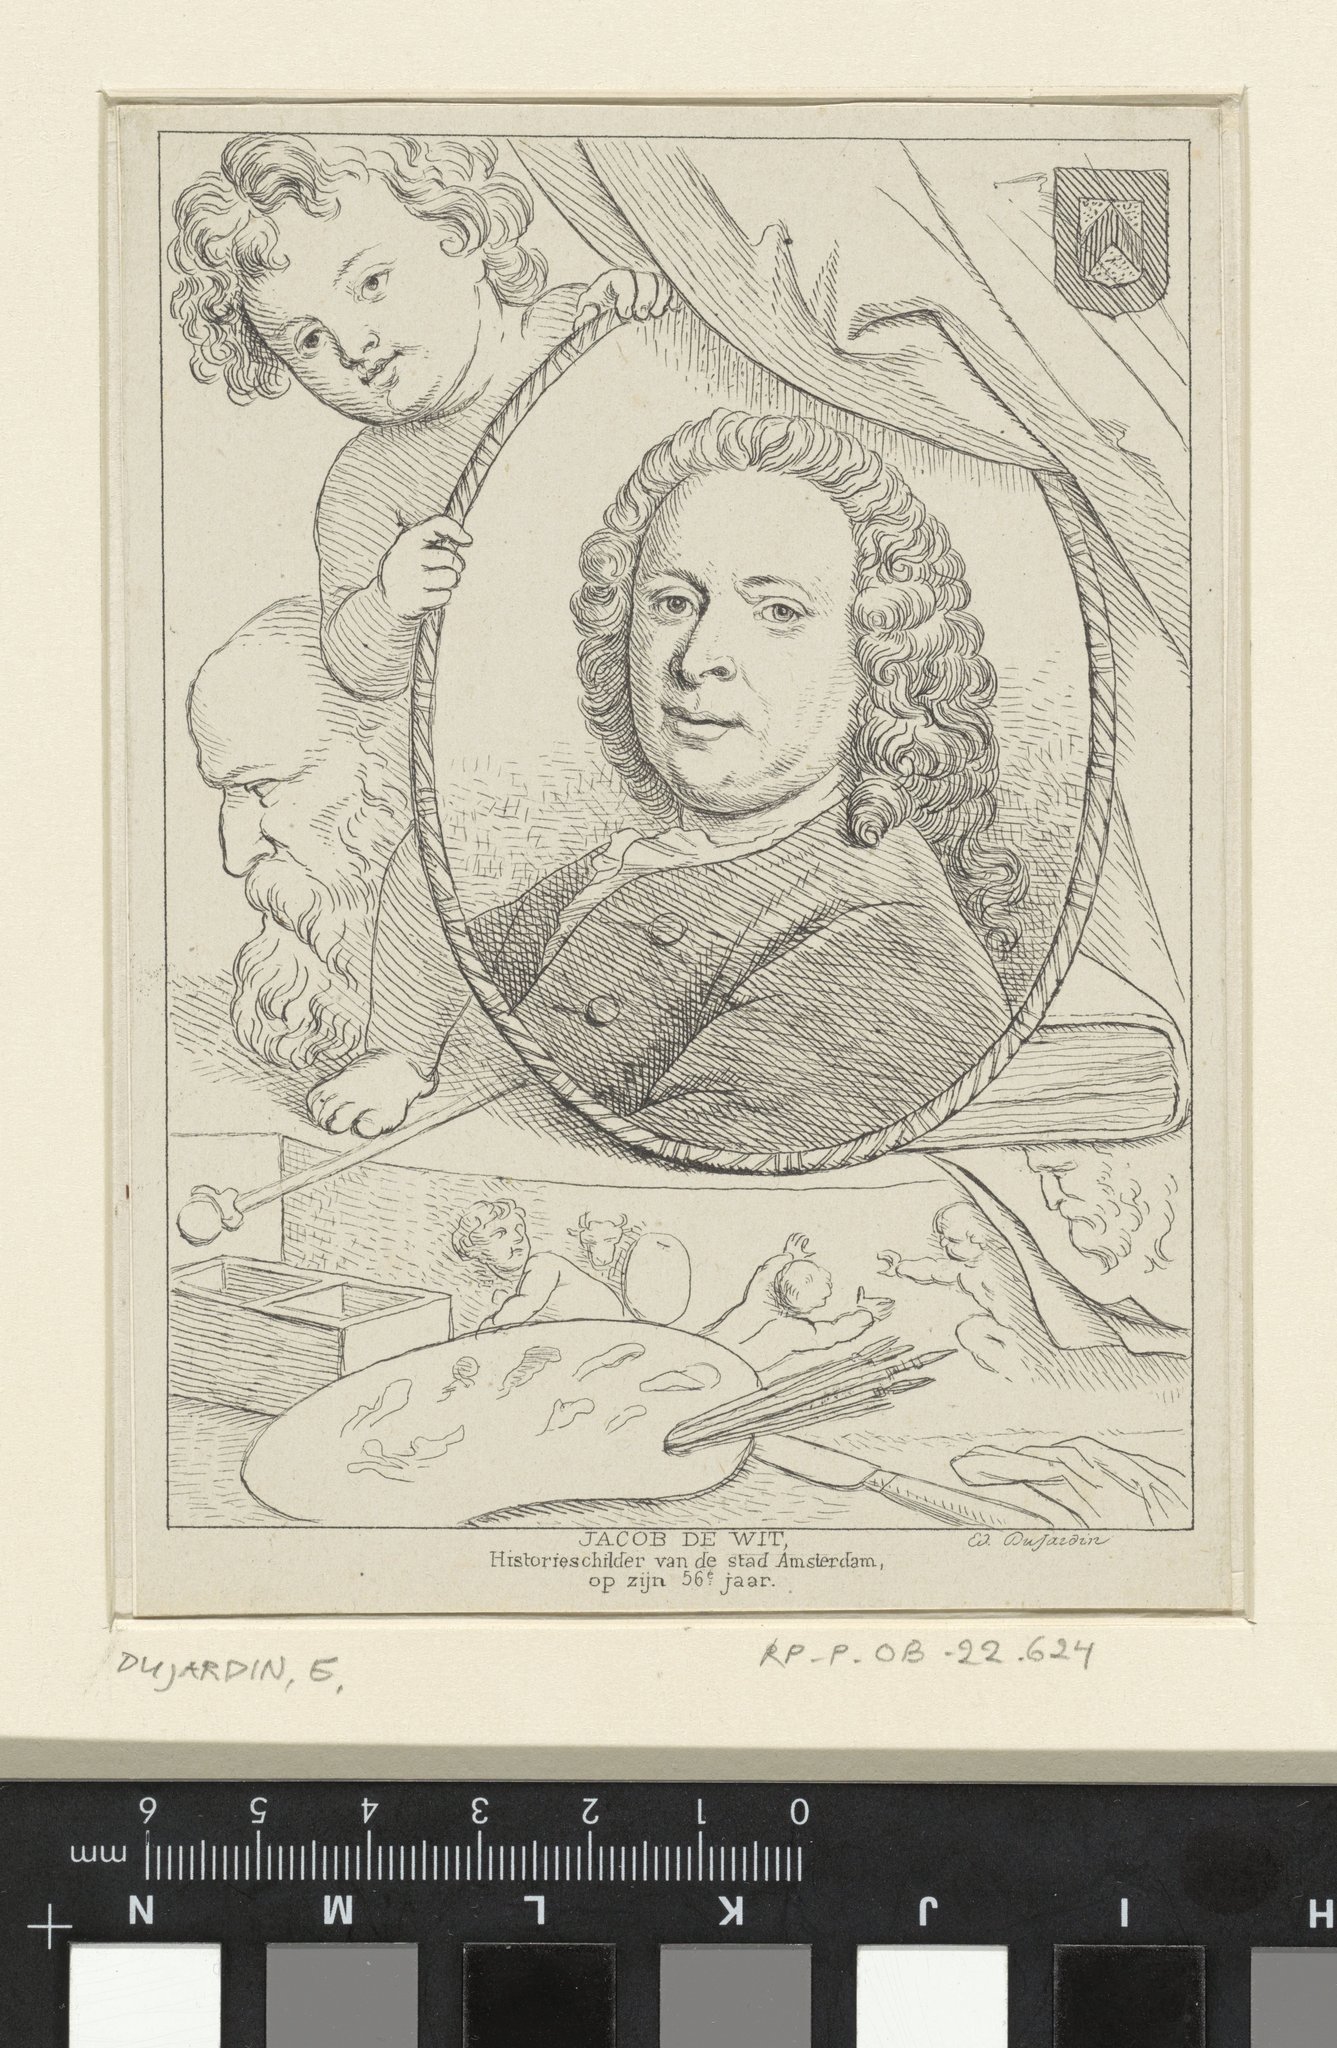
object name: print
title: Portret van Jacob de Wit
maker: edouard dujardin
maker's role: draughtsman, print maker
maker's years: 1817-1889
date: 1827-1889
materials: paper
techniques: engraving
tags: amsterdam, jacob de wit, historical persons, portrait, self-portrait of artist, portrait, self-portrait of graphic artist, portrait, self-portrait of draughtsman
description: Portret van de tekenaar en graveur Jacob de Wit.